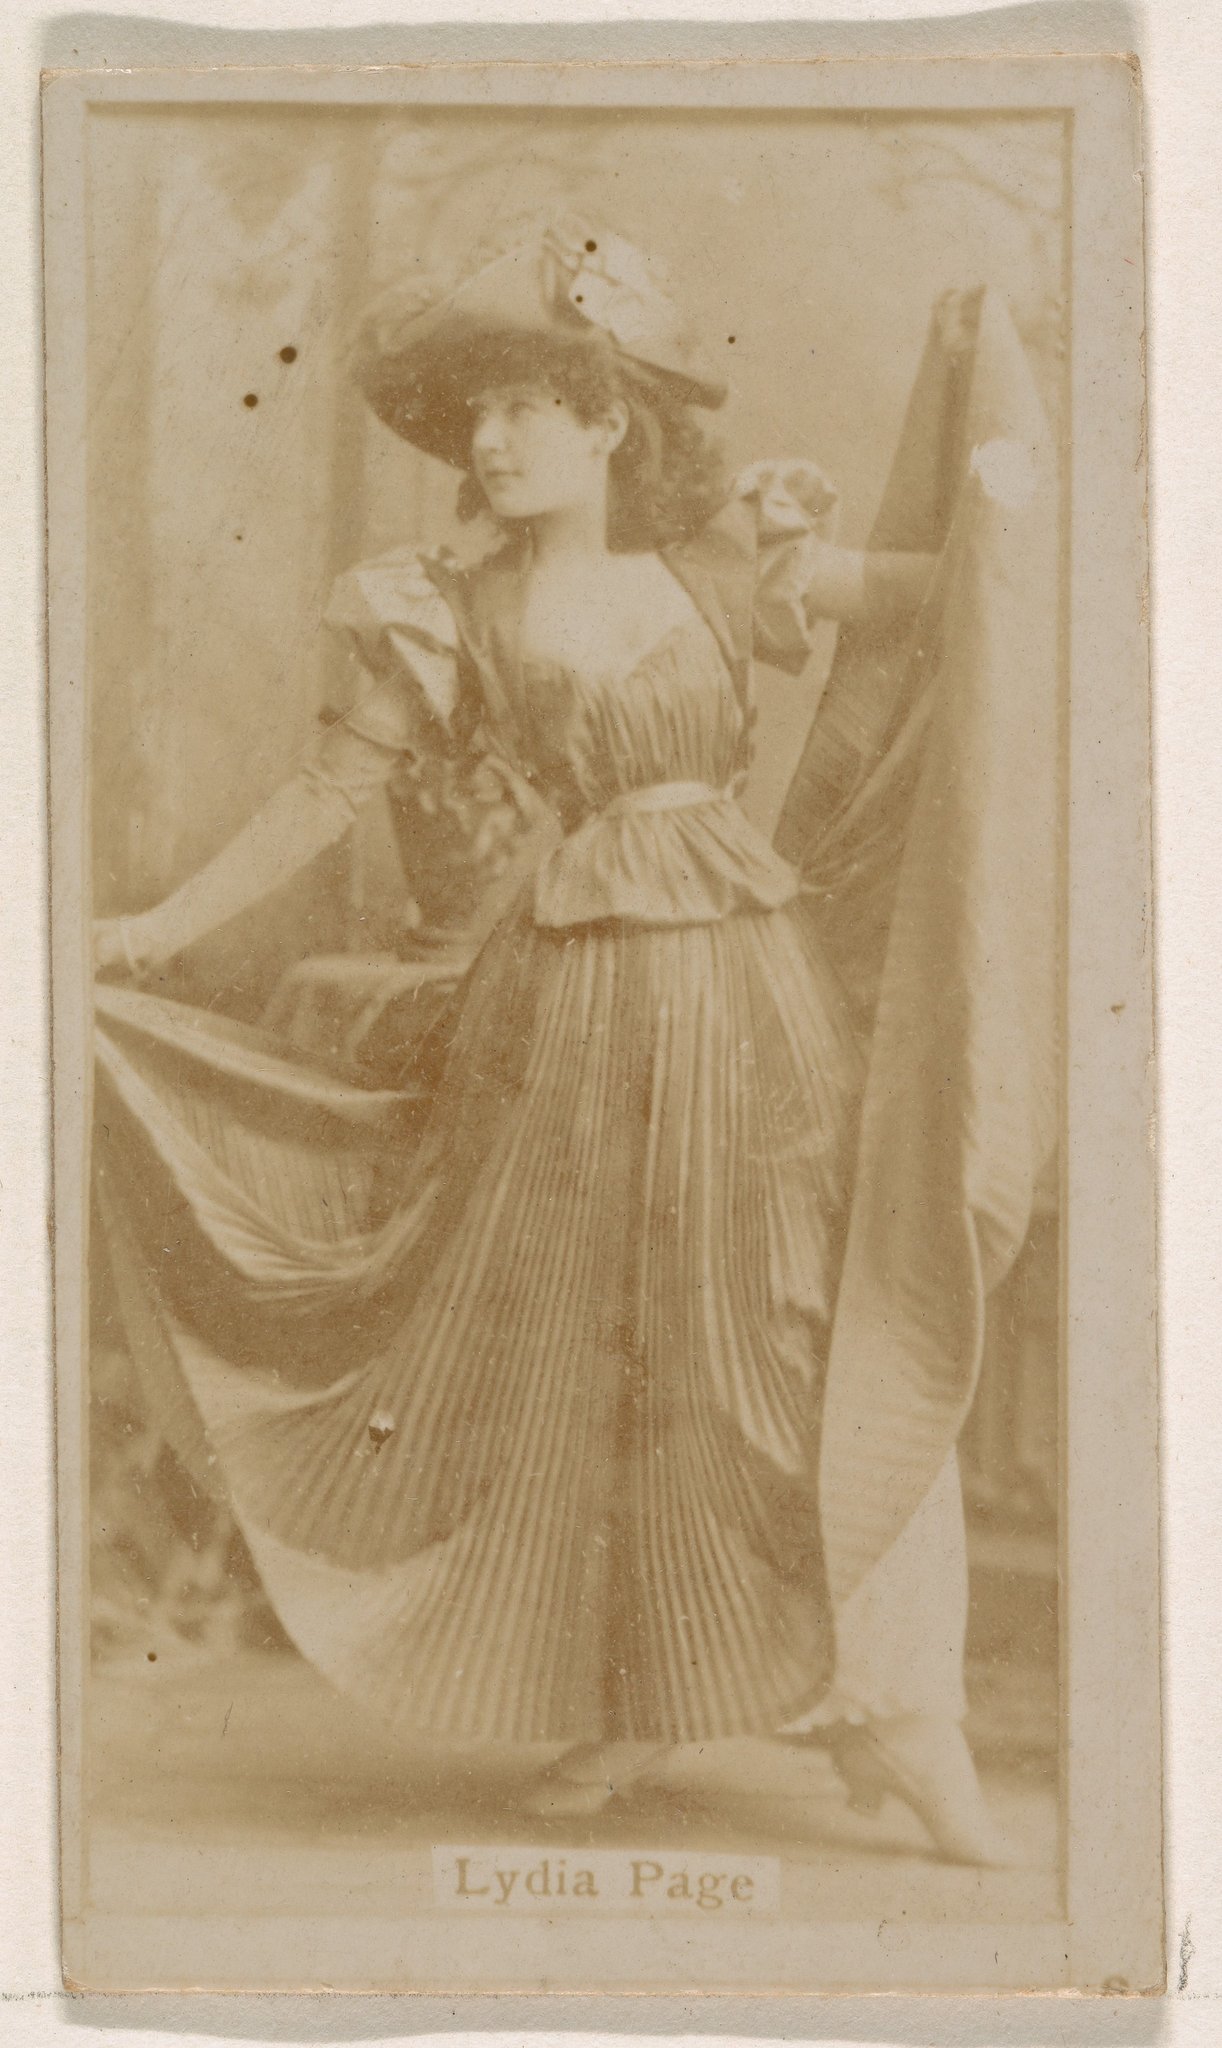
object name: photograph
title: Lydia Page, from the Actresses series (N245) issued by Kinney Brothers to promote Sweet Caporal Cigarettes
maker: kinney brothers tobacco company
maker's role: publisher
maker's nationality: american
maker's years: 1869-2011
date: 1890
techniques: albumen silver print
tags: portraits,women,actresses